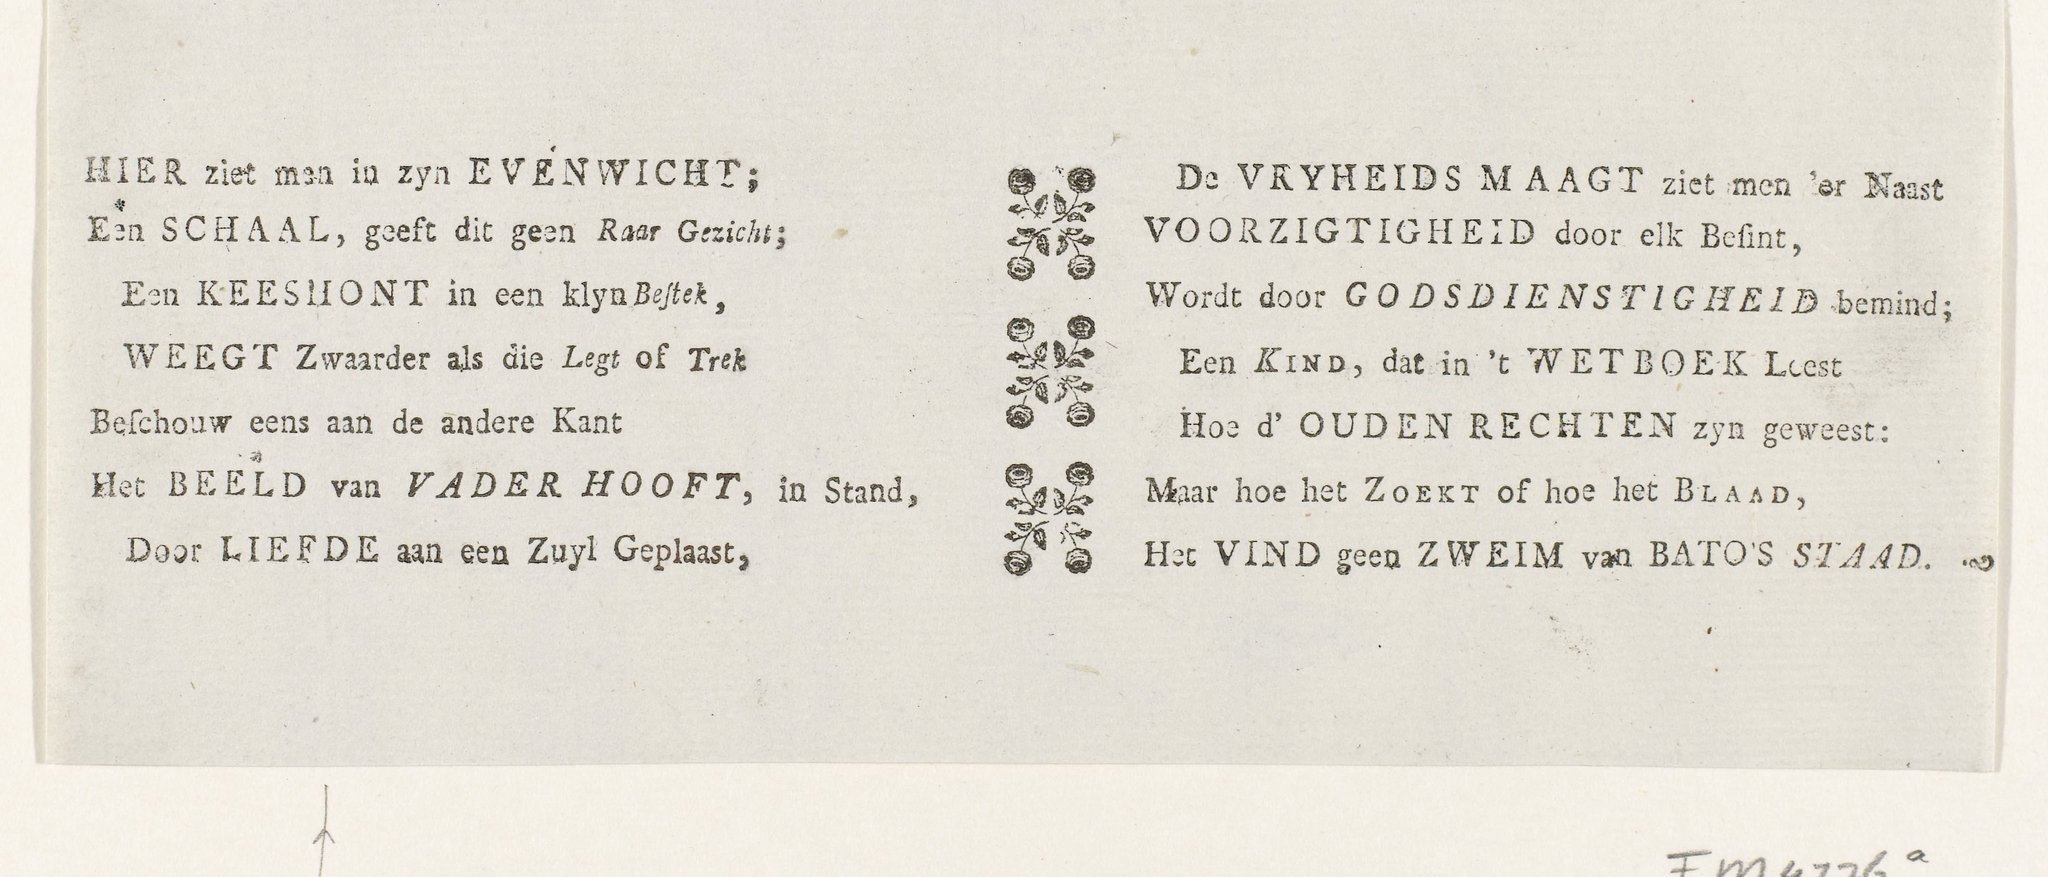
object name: text sheet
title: Tekstblad bij de prent met de Keeshond en Oranjeklanten op de weegschaal, 1787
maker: Anonymous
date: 1787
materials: paper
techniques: letterpress printing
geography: northern netherlands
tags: amsterdam, mayor, hendrik danielsz. hooft, patriots (1780-1795)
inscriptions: collector's mark: Lugt 2228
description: Tekstblad bij de prent met de Allegorie waarin een kleine keeshond (patriotten) en Oranjeklanten op een weegschaal aan een boom worden gewogen, 1787. Vers van veertien regels in twee kolommen.